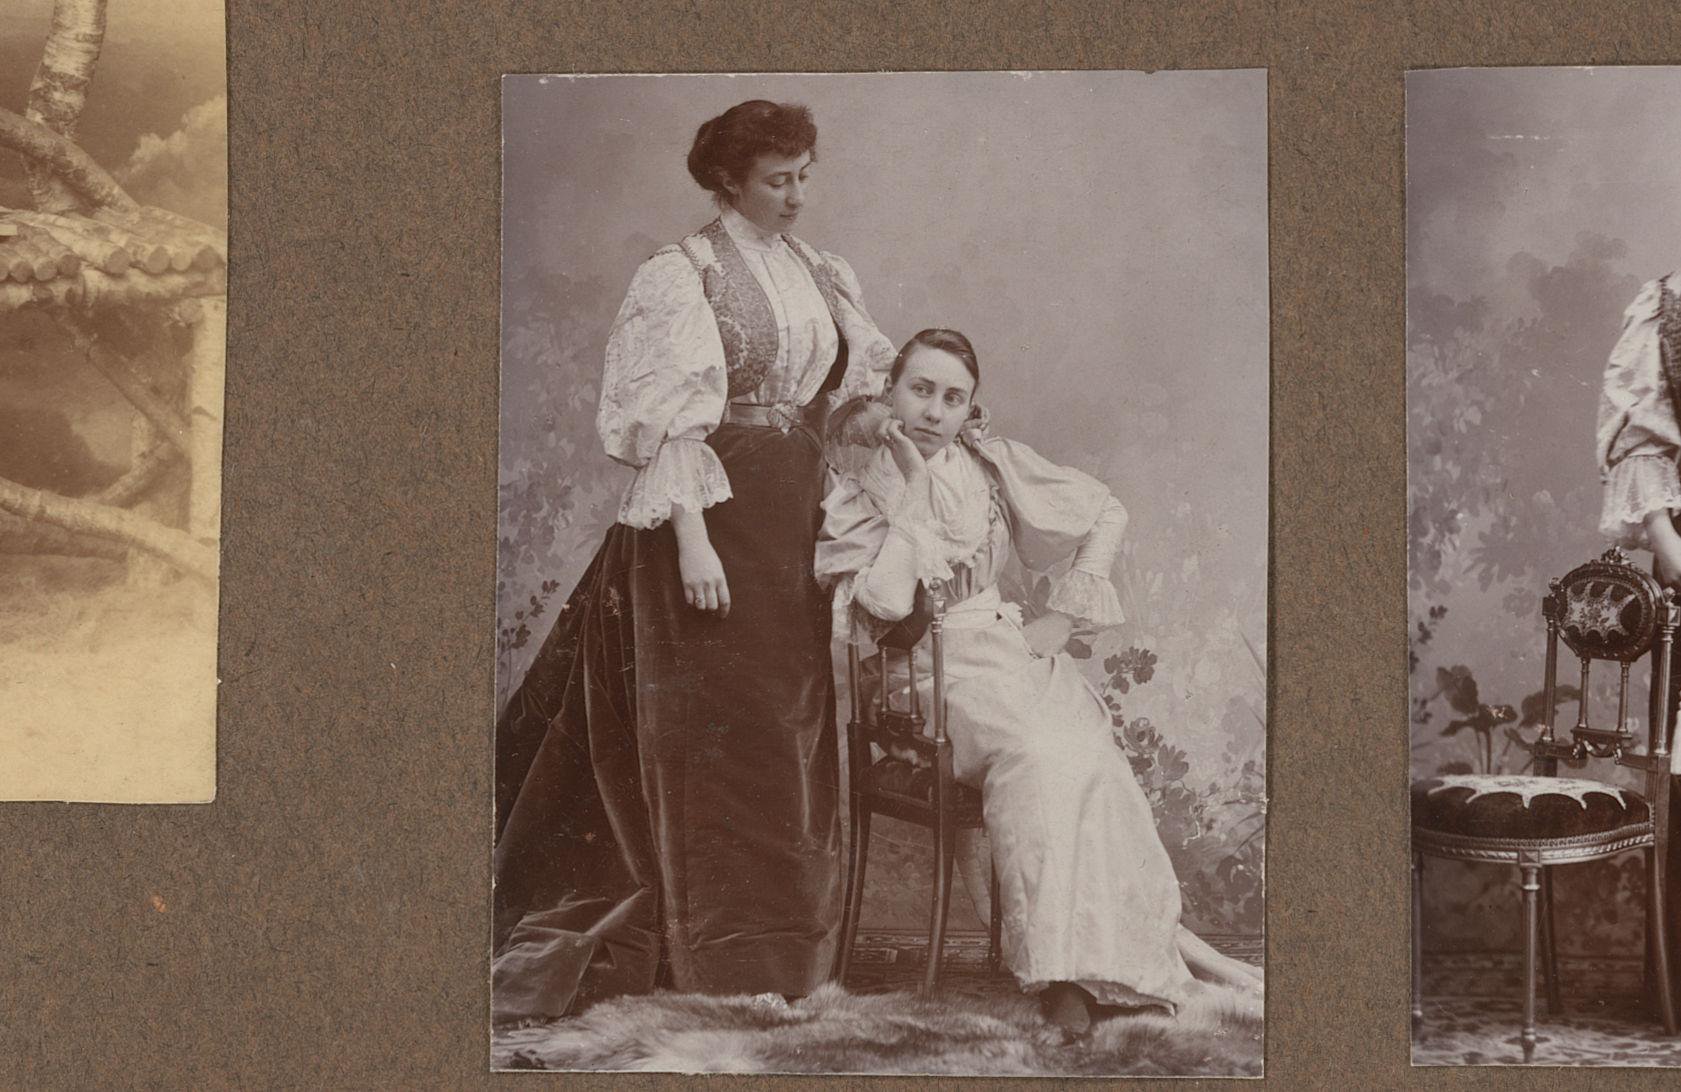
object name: photograph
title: Studioportret van twee vrouwen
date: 1870-1920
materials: photographic support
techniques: photography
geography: amsterdam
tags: netherlands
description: Foto op bruin albumblad 34 van familiealbum van Alphons Diepenbrock.